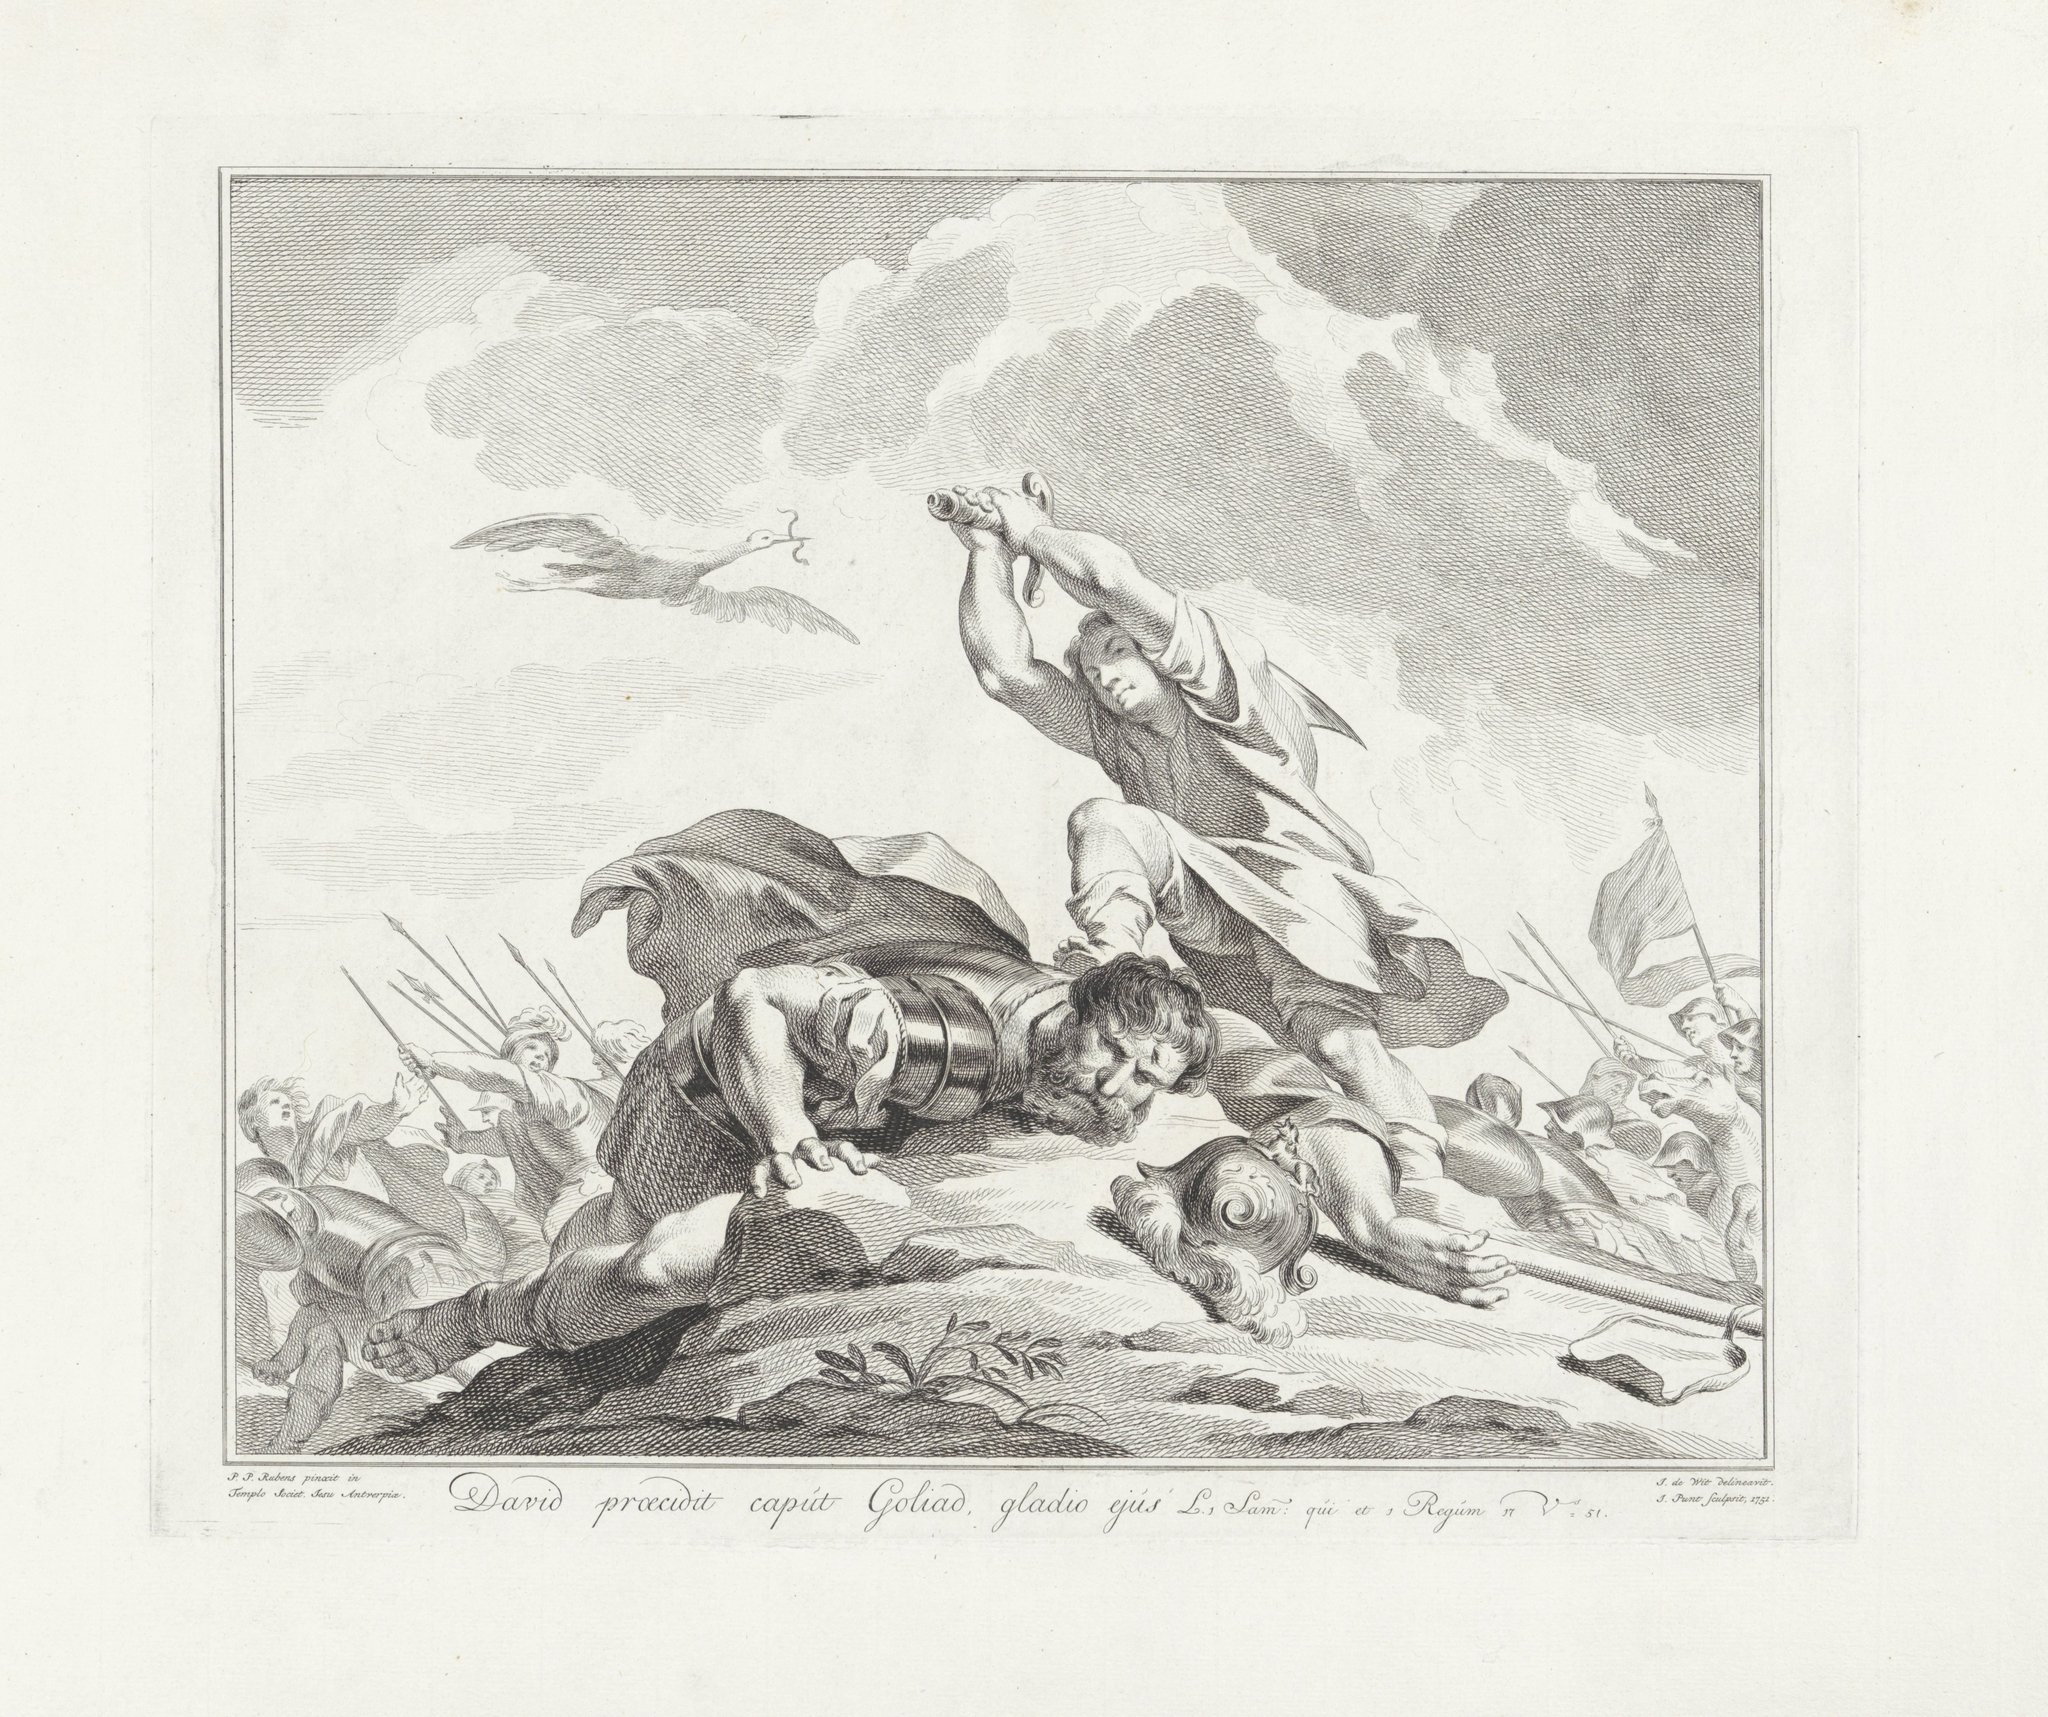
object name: print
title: David onthoofdt Goliat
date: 1752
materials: paper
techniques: engraving, etching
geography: amsterdam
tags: david beheads goliath with a sword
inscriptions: date: ‘1752’, collector's mark: Lugt 240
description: Goliat ligt op de grond en David staat op het punt zijn hoofd af te houwen. Onder de rechthoekige voorstelling een vers in het Latijn uit 1 Sam. 17:51.